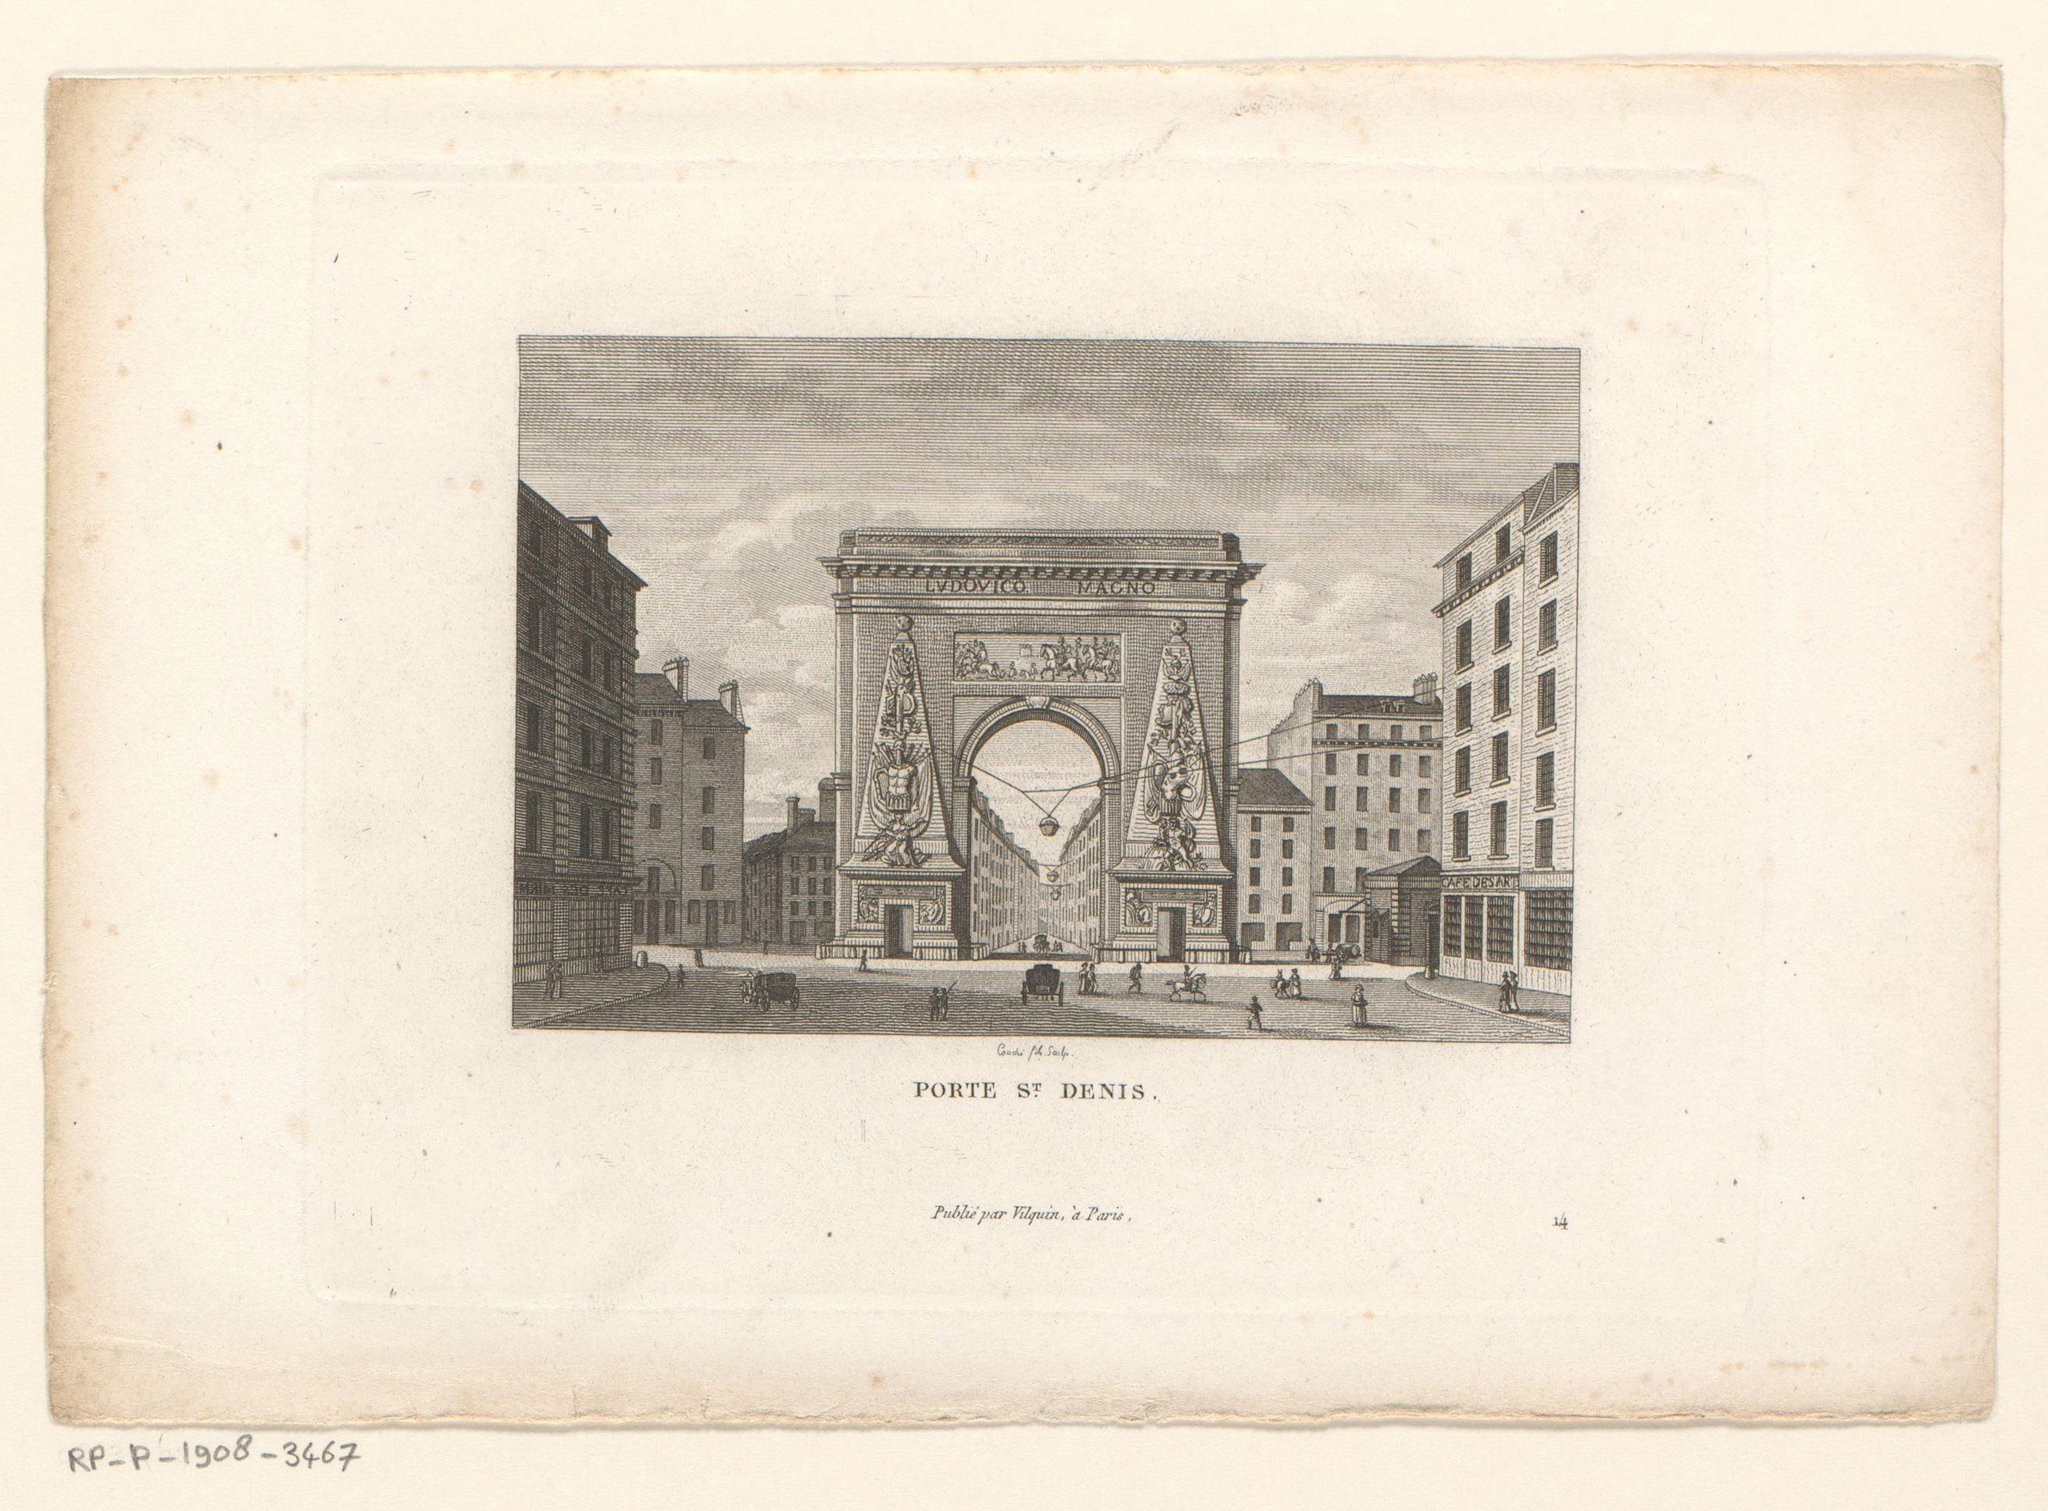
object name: print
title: Gezichten op Parijs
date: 1818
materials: paper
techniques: etching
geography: paris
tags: city-view in general; 'veduta', triumphal arch, paris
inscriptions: collector's mark: Lugt 2228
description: Maakt deel uit van een serie met 60 platen van monumenten, kathedralen en paleizen in Parijs.